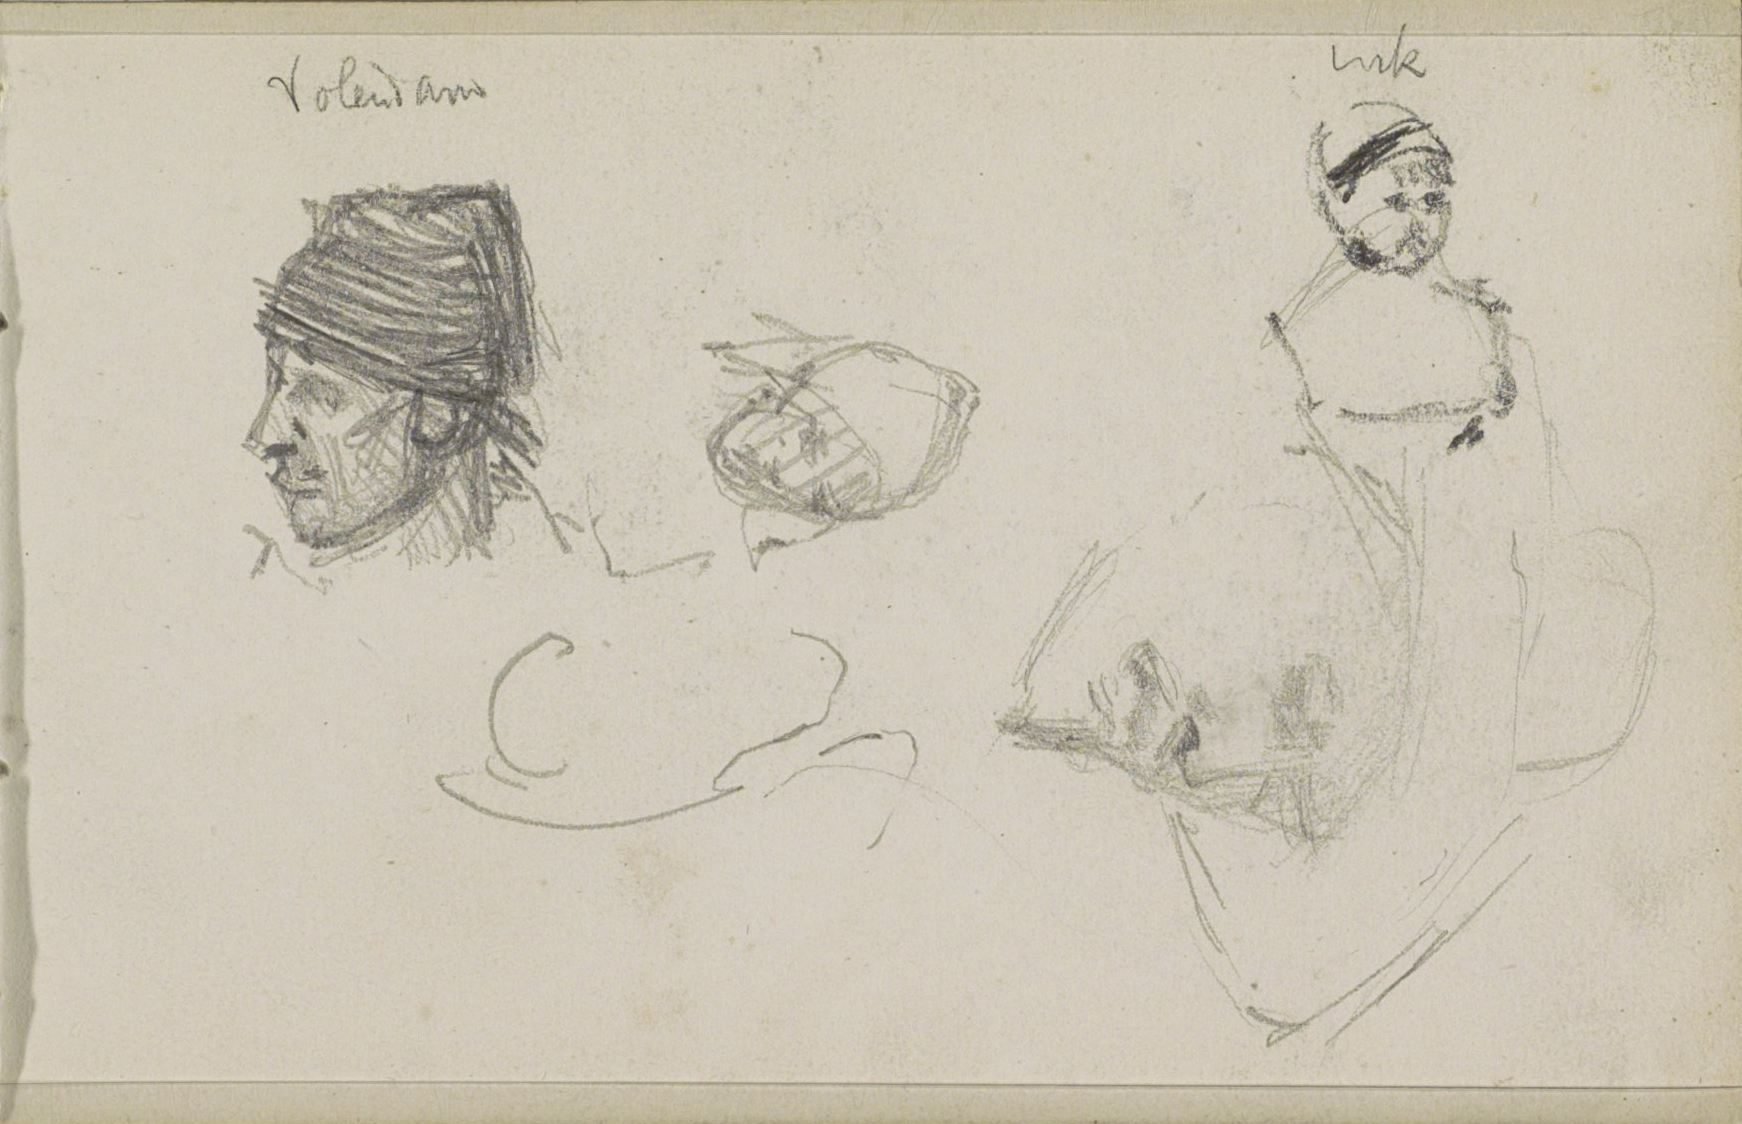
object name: sketchbook leaf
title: Man in Volendamse klederdracht en een kind met een Urker muts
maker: george clausen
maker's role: draughtsman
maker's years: 1852-1912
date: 1875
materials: paper, pencil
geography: urk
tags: head (human), child, folk costume, regional costume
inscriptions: annotation: ‘Volendam/ Urk’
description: Blad 7 recto uit een schetsboek met 38 bladen.